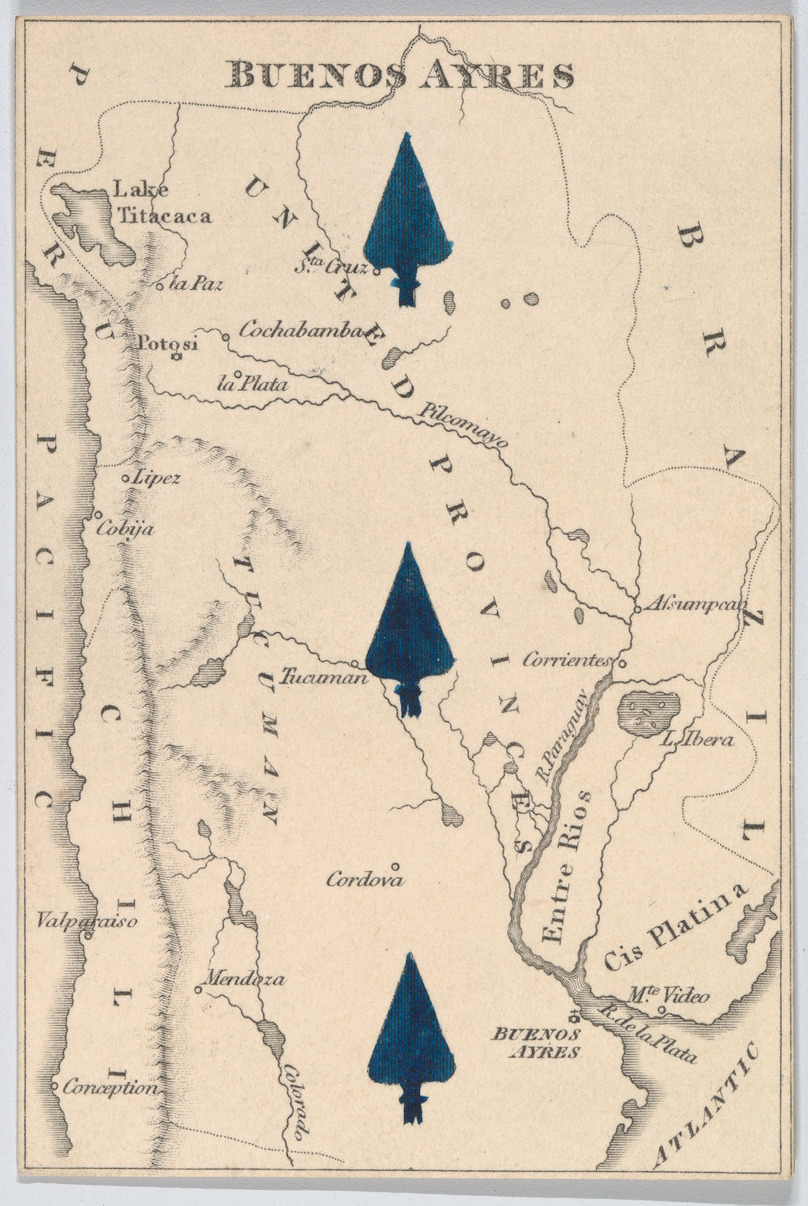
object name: print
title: Buenos Aires, from "Court Game of Geography"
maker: william and henry rock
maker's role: publisher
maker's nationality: british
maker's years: 1821-1884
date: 1838-1855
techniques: engraving, hand coloring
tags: playing cards,maps